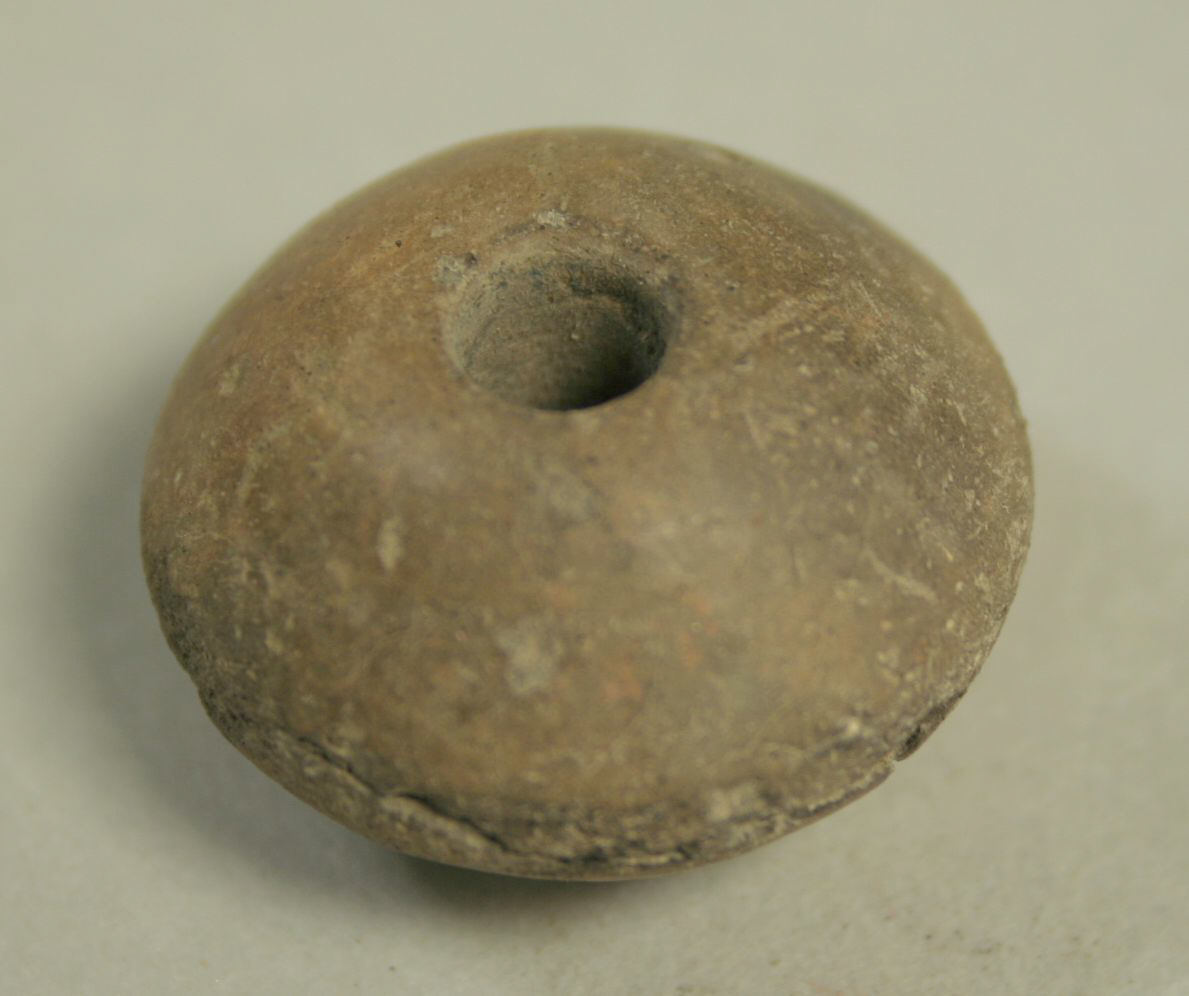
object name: spindle whorl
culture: peruvian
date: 901-1600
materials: ceramic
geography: peru